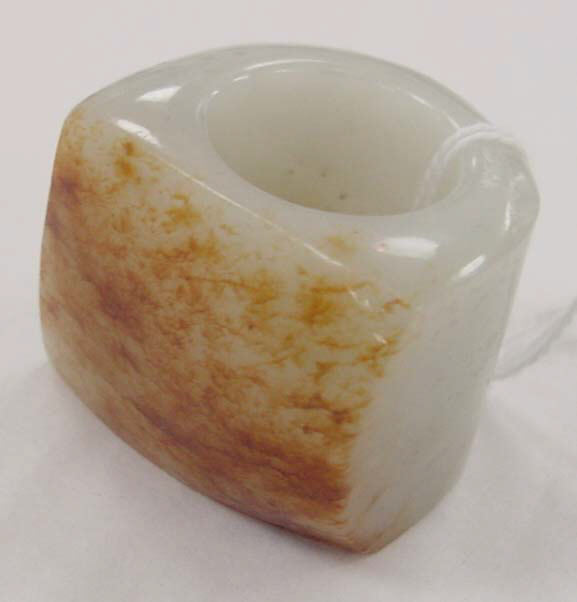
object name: ring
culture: chinese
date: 1801-1900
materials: jade